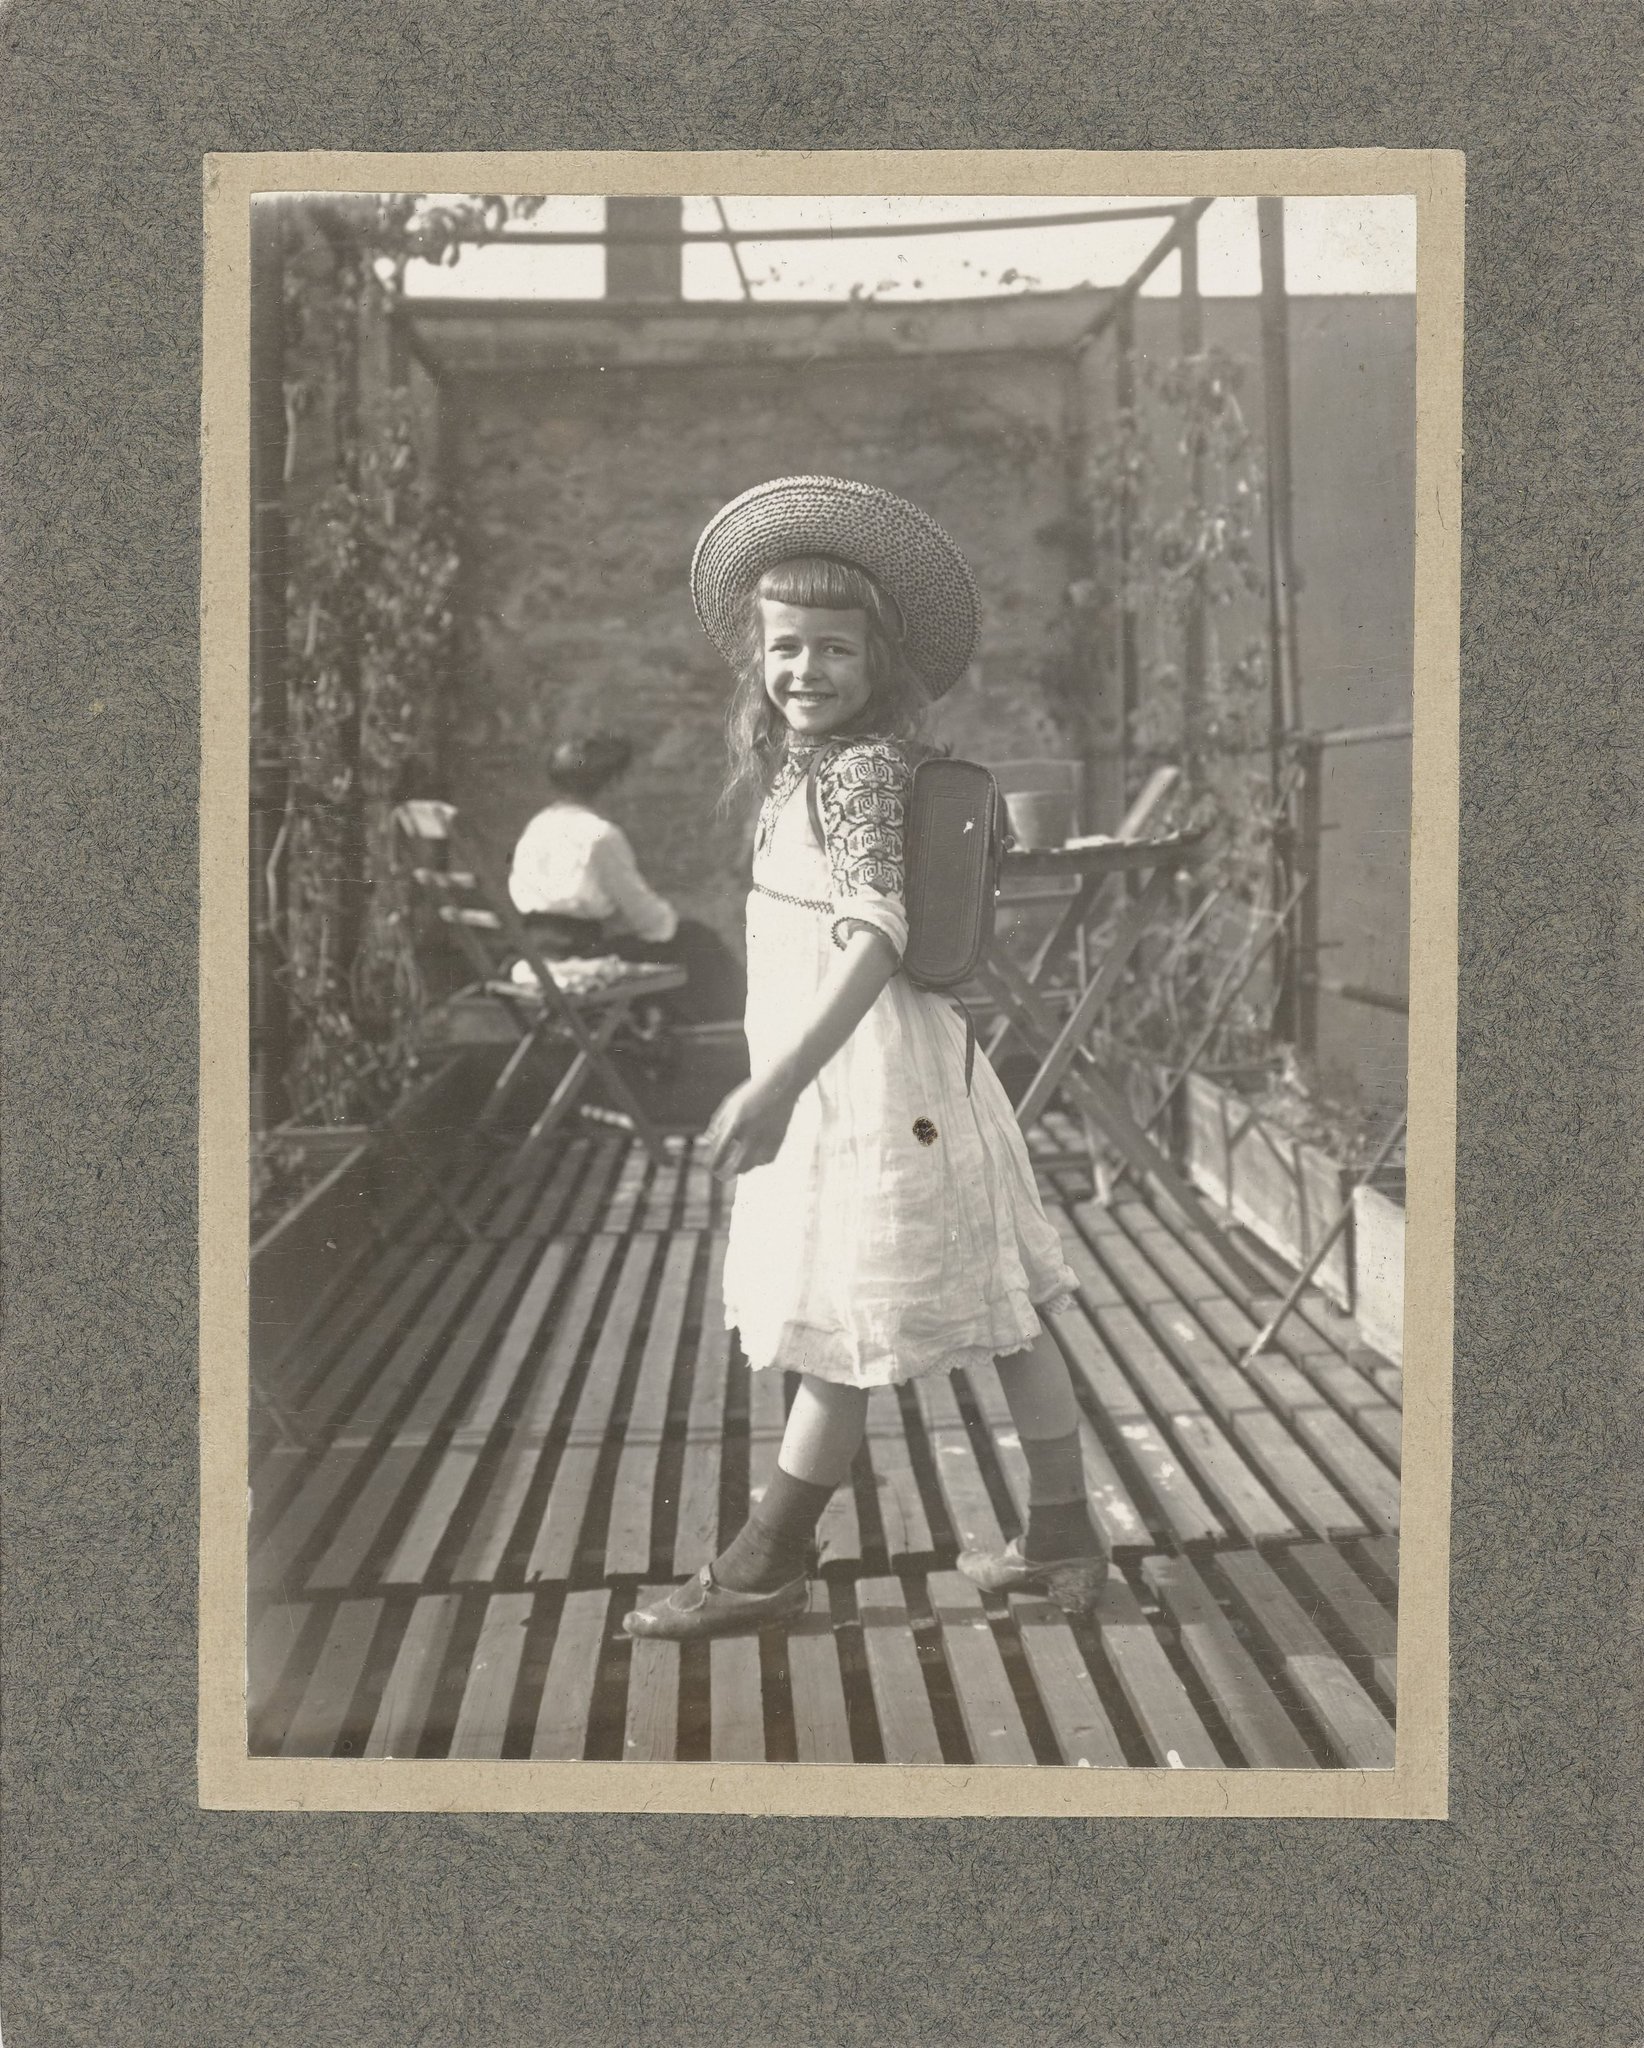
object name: photograph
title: Marba Titzenthaler, dochter van de fotograaf, op het dakterras van het woonhuis in de Friedrichstrasse, Berlijn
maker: waldemar titzenthaler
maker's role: fotograaf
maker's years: 1869-1937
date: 1917-1920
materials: paper, cardboard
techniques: gelatin silver print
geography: berlin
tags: berlin, girl (child between toddler and youth)